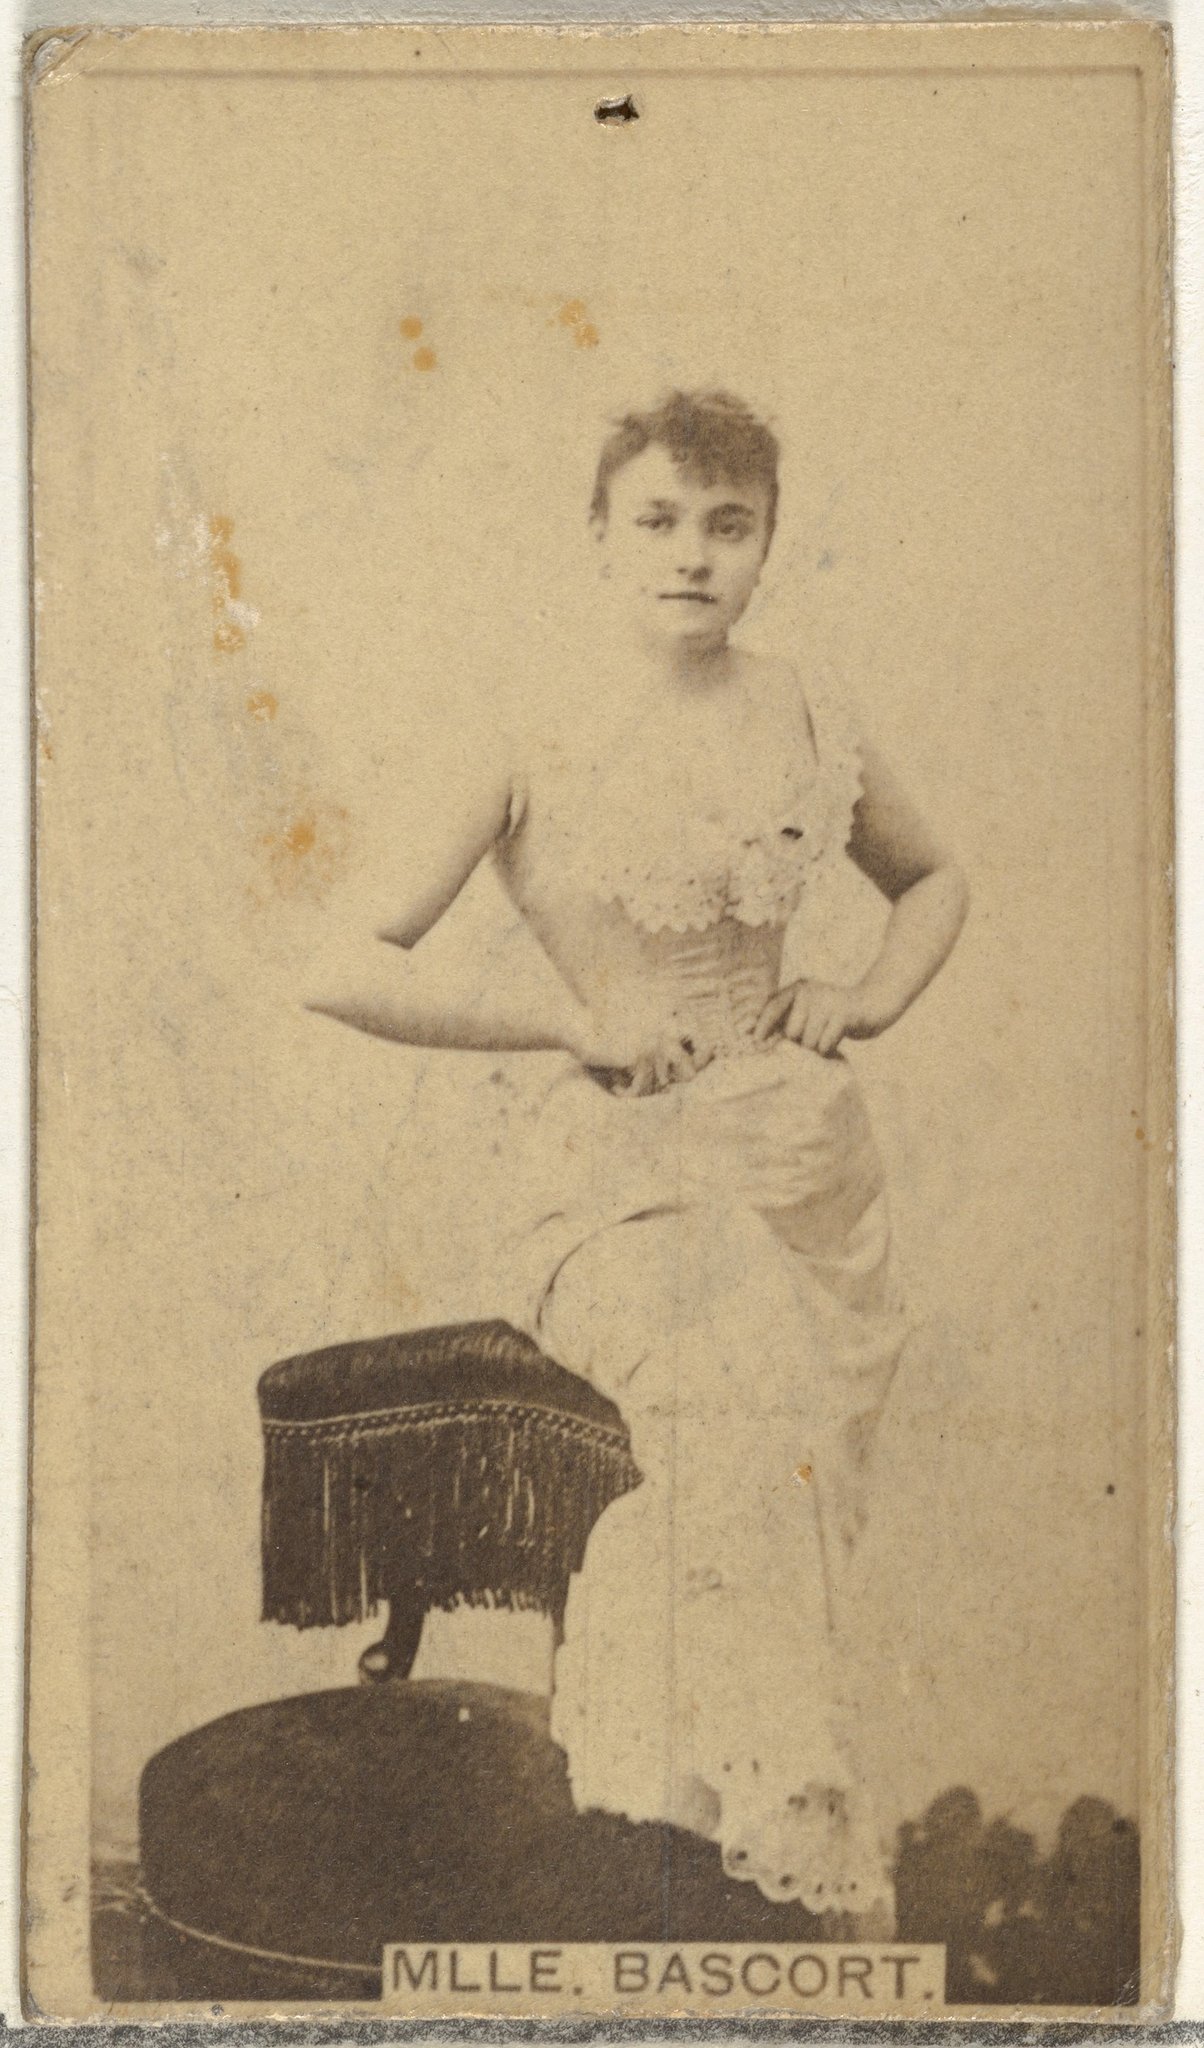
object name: photograph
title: Mlle. Bascort, from the Actors and Actresses series (N145-8) issued by Duke Sons & Co. to promote Duke Cigarettes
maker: w. duke, sons & co.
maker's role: publisher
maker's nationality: american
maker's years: 1870-1920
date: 1891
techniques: albumen silver print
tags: portraits,women,actresses